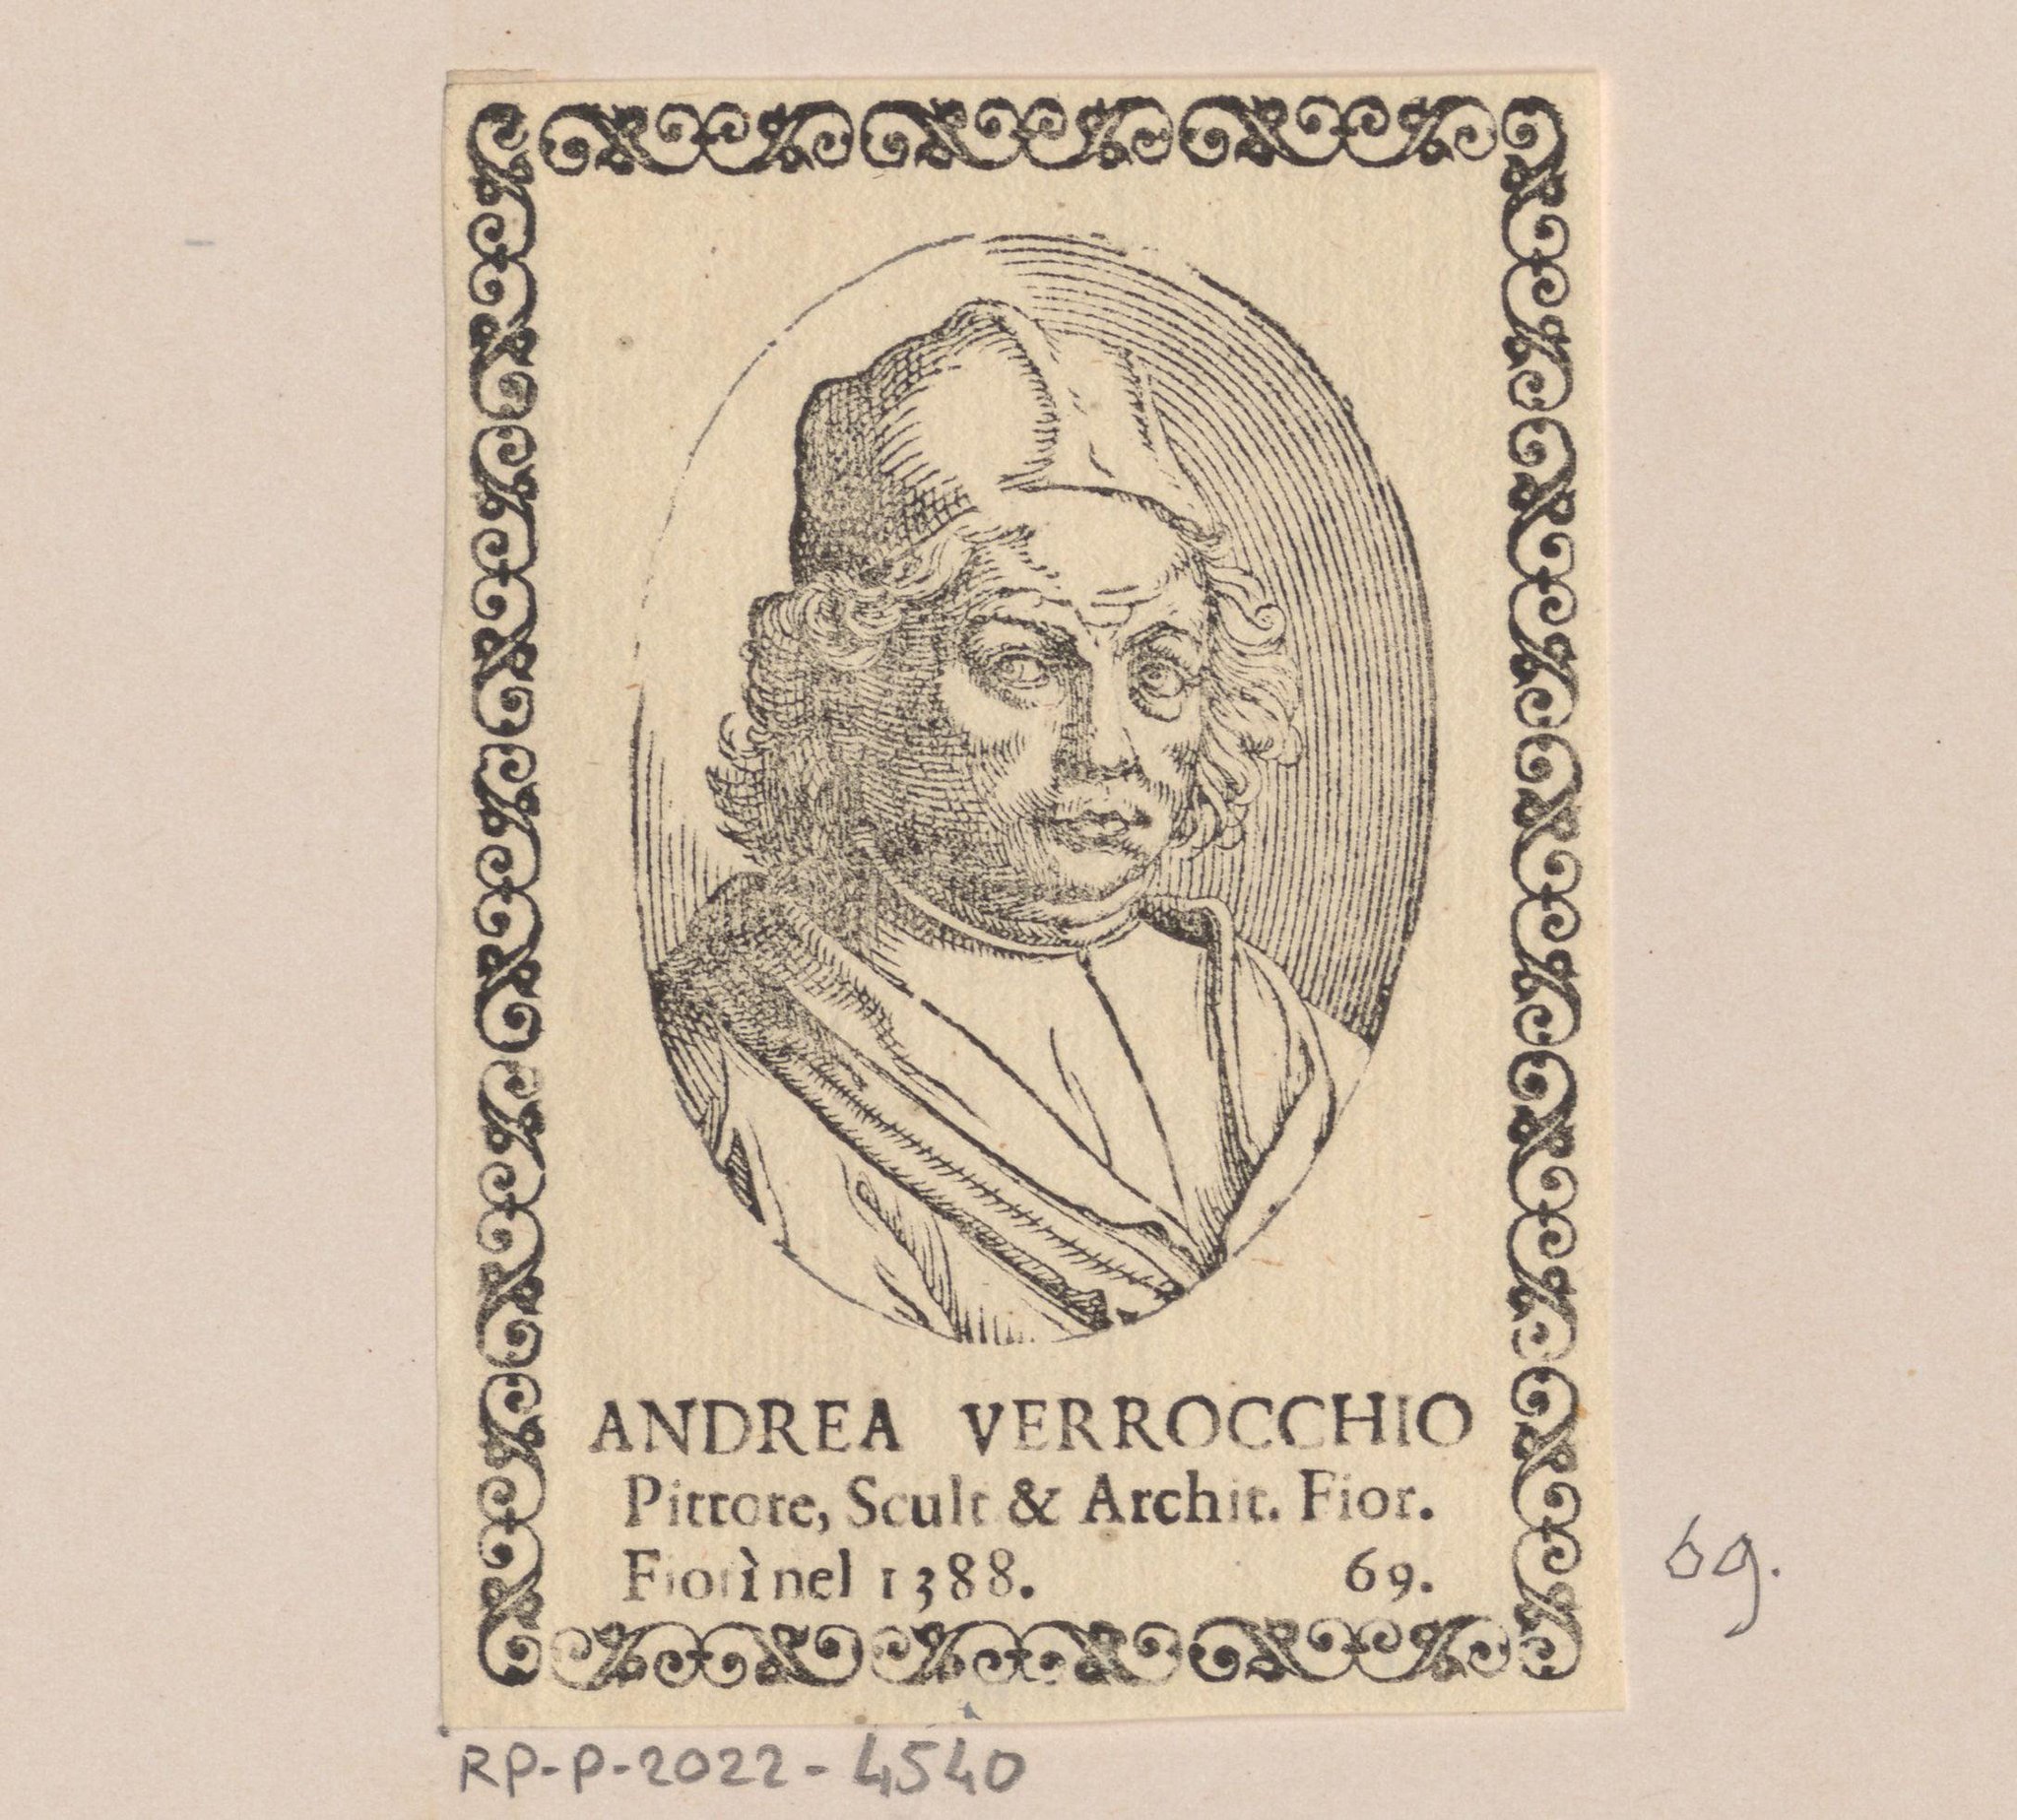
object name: print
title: Portret van Andrea del Verrocchio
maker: cristoforo coriolano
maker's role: print maker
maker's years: 1540-1610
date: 1568-1663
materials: paper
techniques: woodcut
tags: venice, painter, sculptor, jeweler, andrea del verrocchio, historical persons, portrait, self-portrait of painter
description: Prent komt waarschijnlijk uit een editie van Vasari’s Vite. De prent is met een andere omlijsting gebruikt in de editie uit 1568, en mogelijk in de edities van 1647 en 1663. Waarschijnlijk zijn de houtsnedes met deze omlijsting gemaakt door Cristoforo Coriolano.